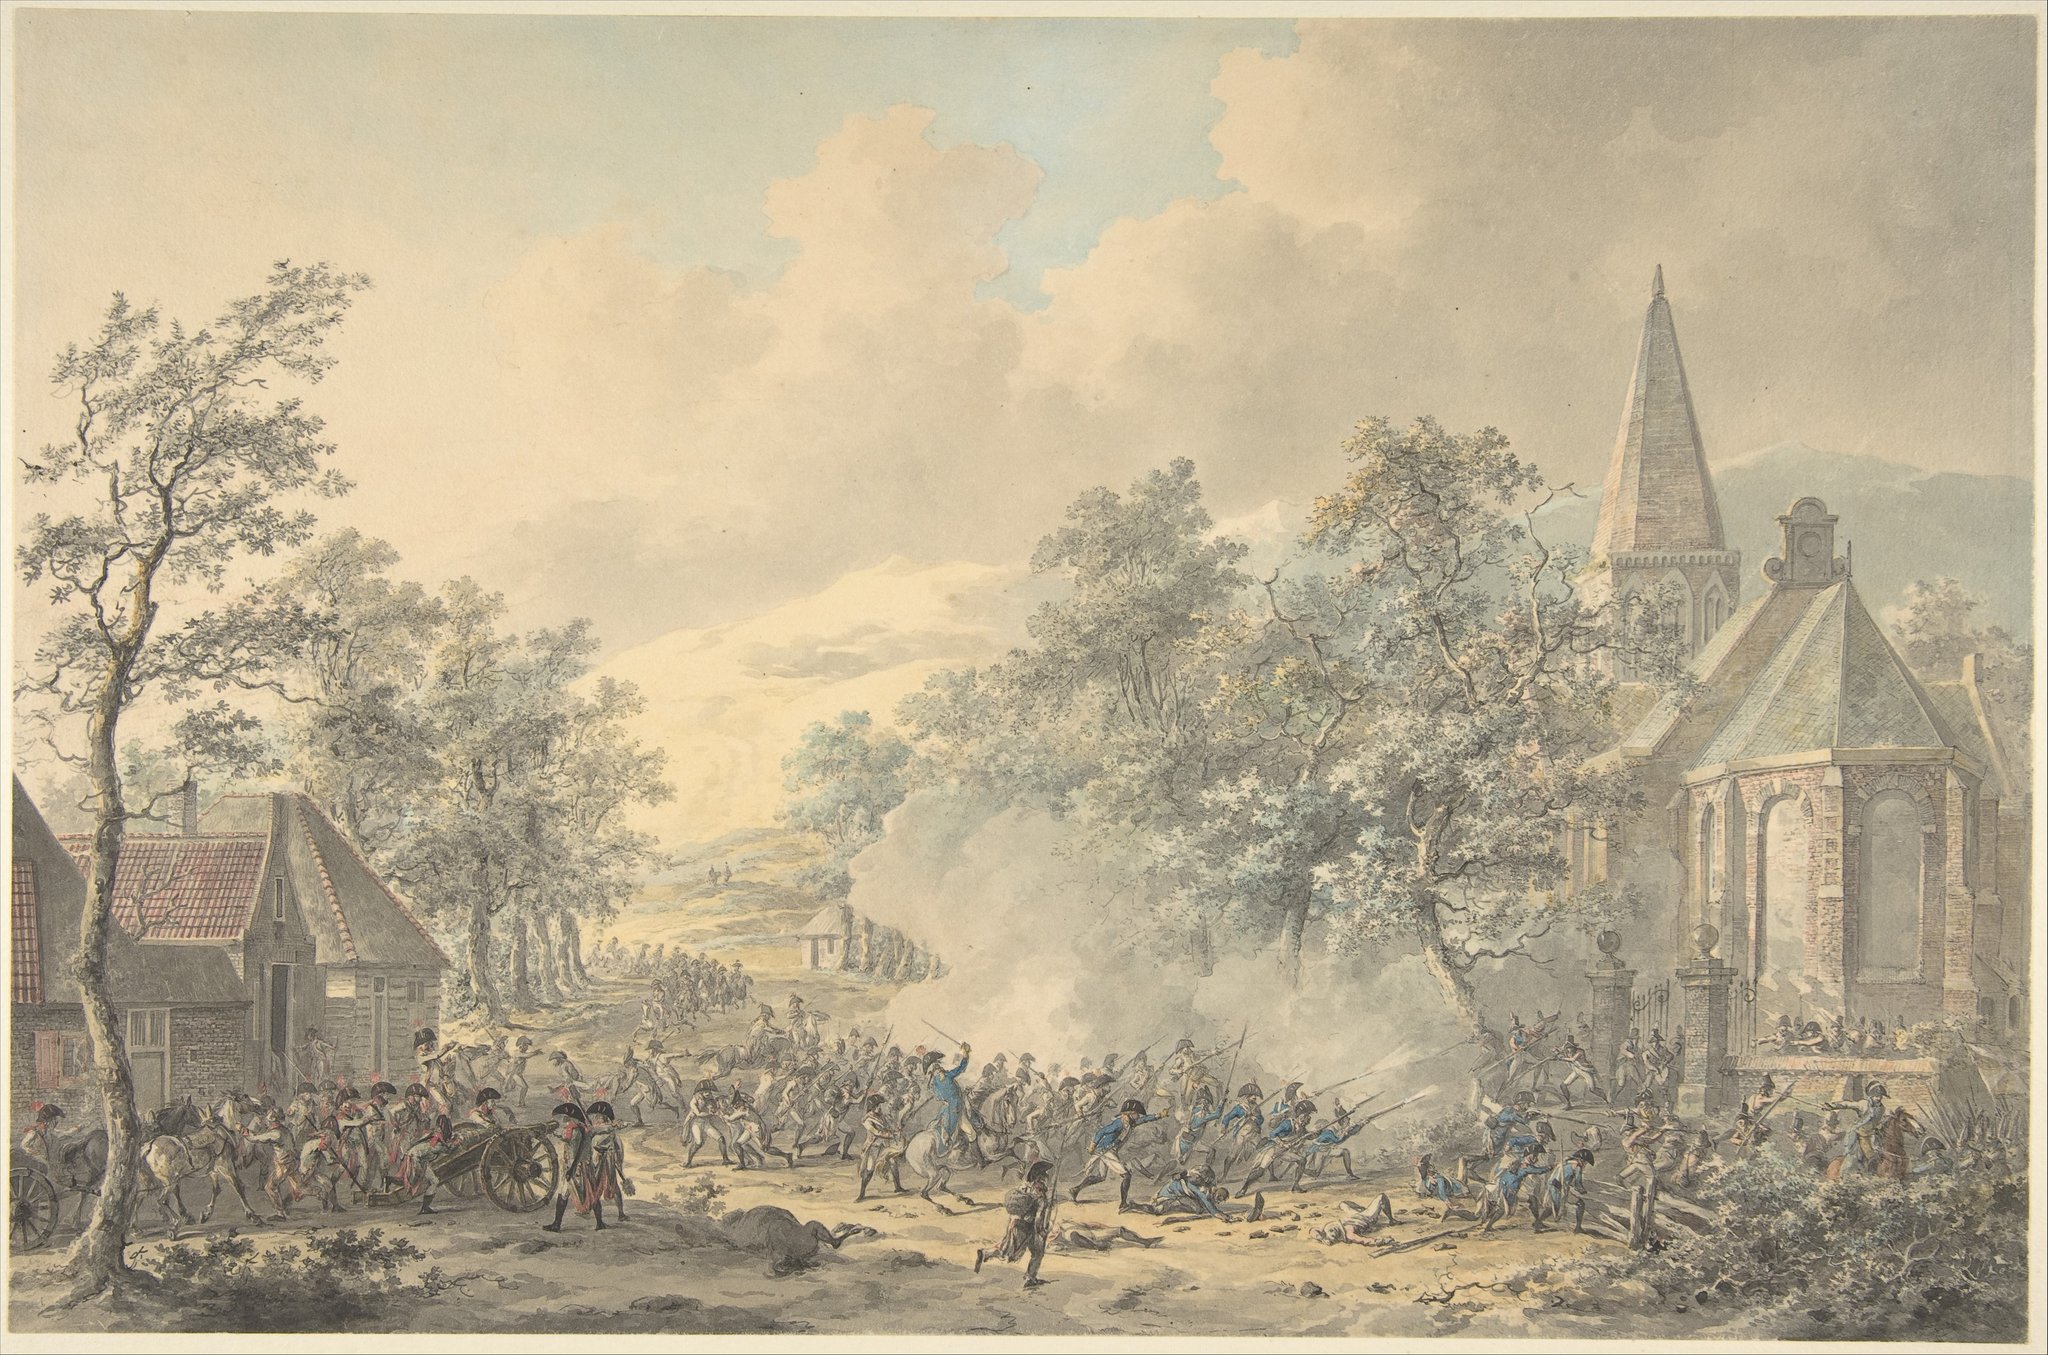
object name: drawing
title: Battle Scene with Church at right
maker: dirk langendijk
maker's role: artist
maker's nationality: dutch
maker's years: 1748-1805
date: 1790-1800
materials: watercolor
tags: houses,churches,battles,crowd